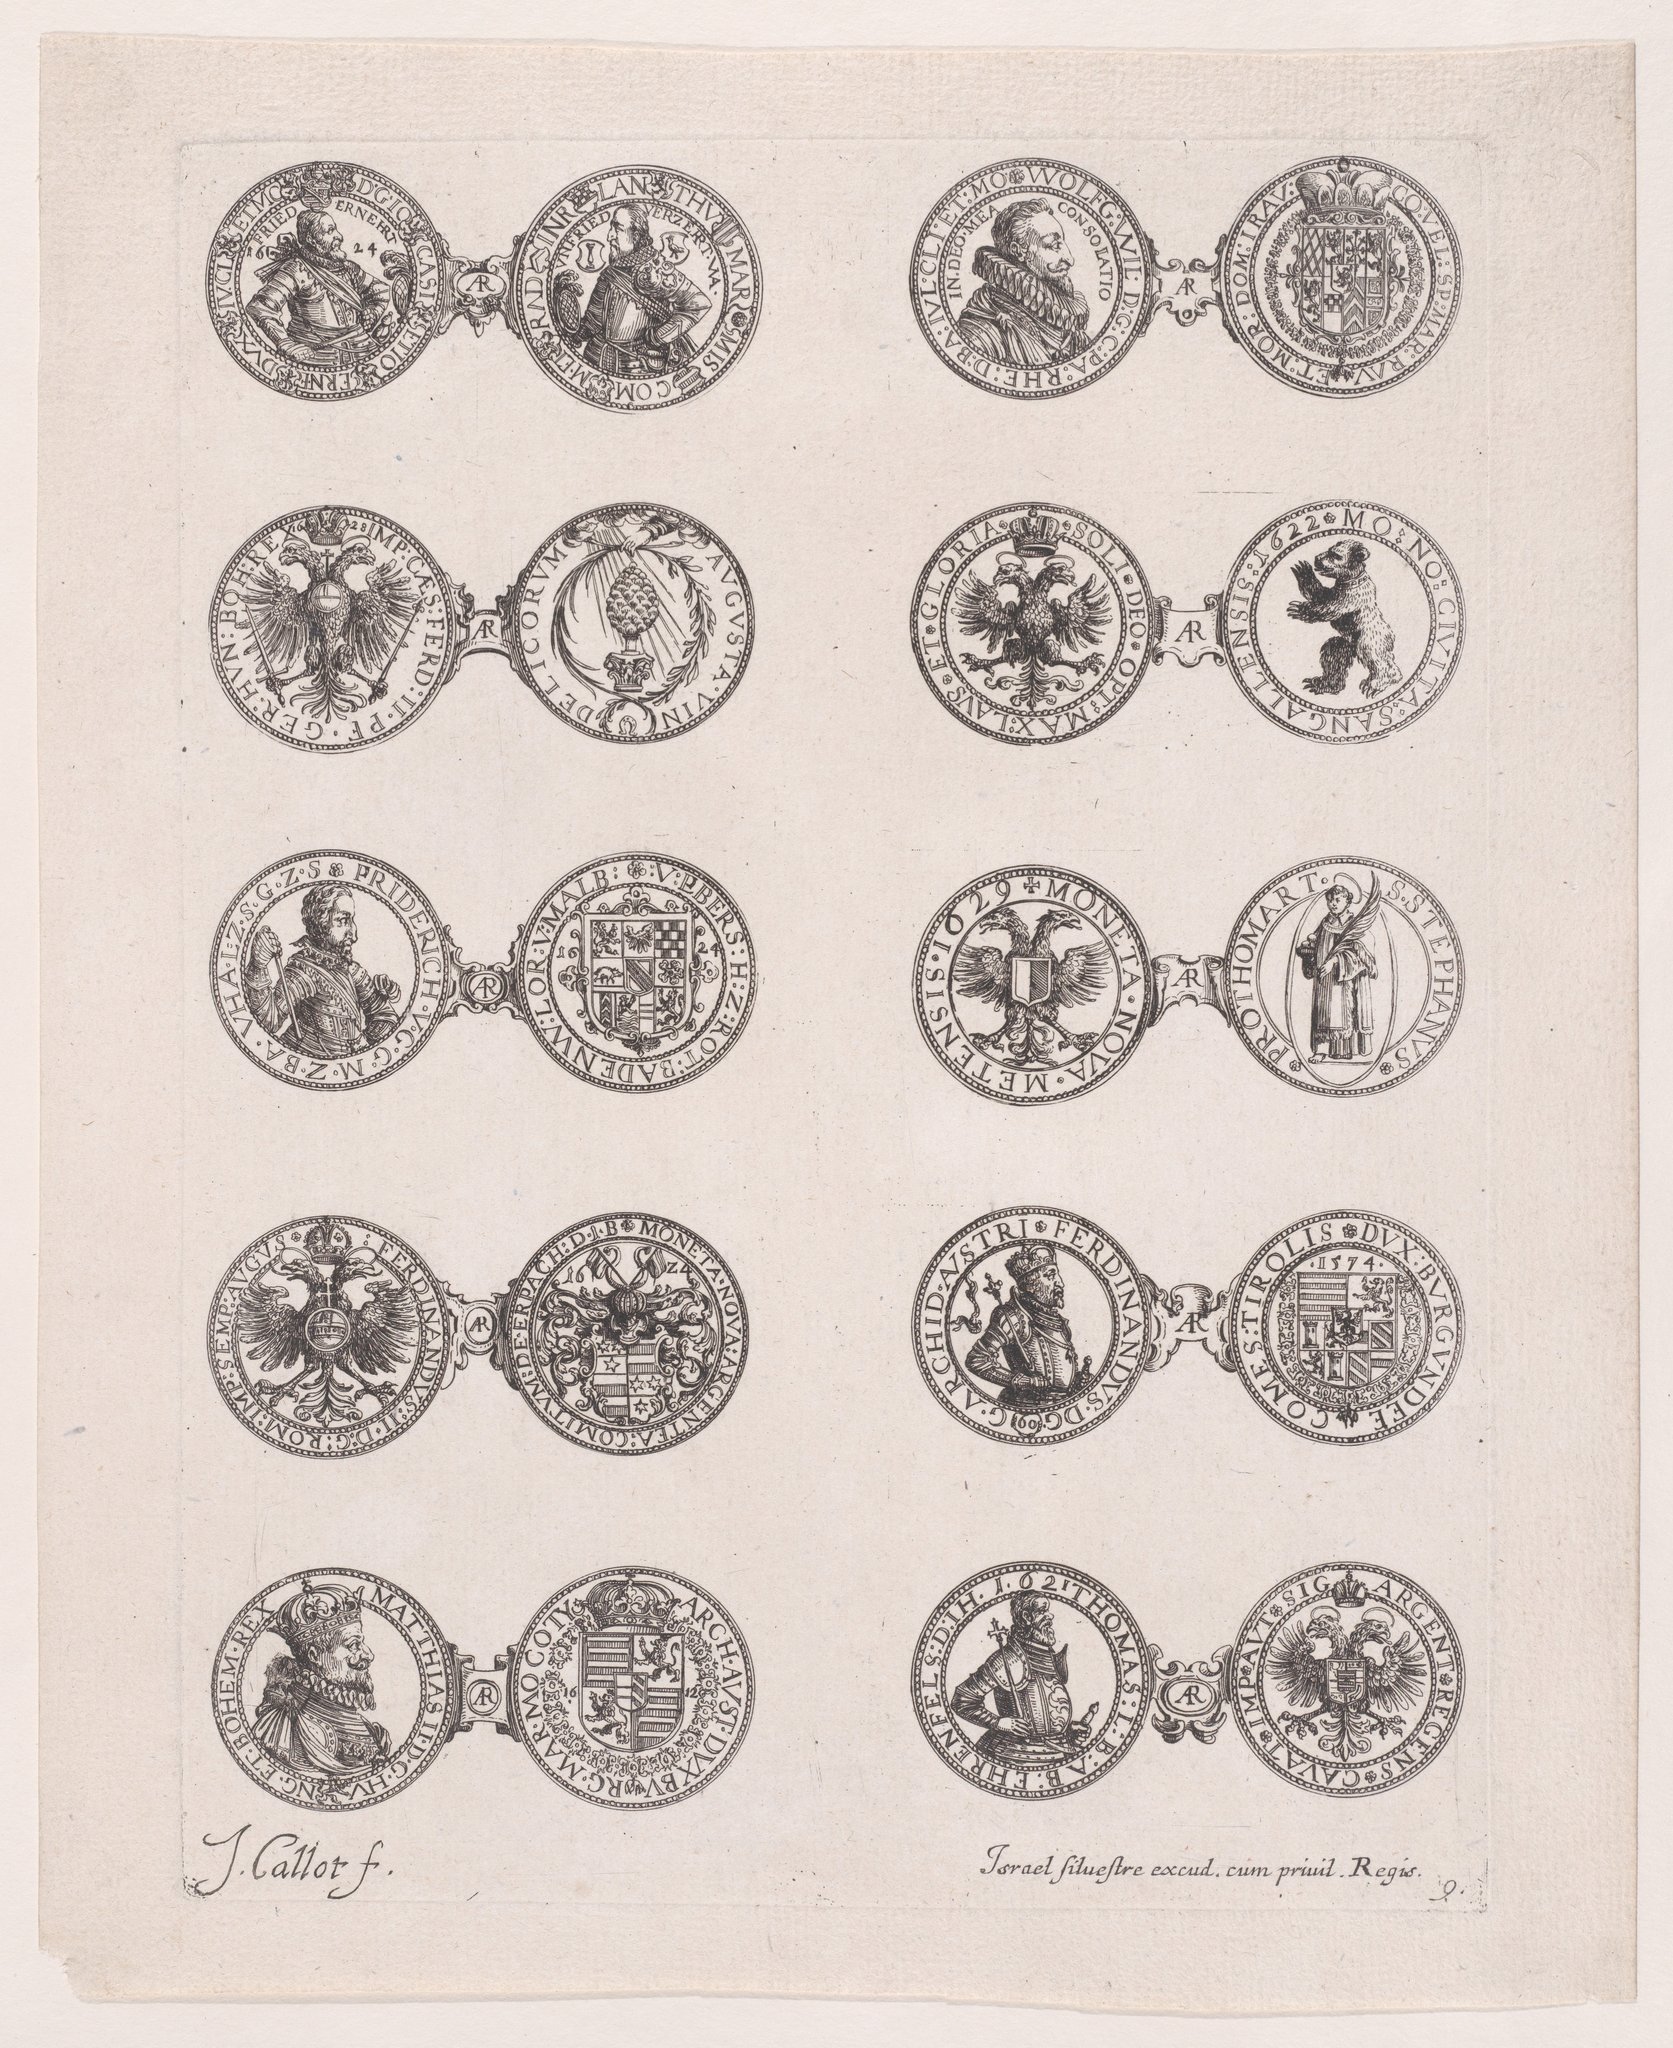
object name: print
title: Plate 9, Featuring 10 Coins Issued by European Princes in the 16th and 17th centuries, from "Les Monnaies" (The Currencies)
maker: jacques callot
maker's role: artist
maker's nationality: french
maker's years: 1592-1635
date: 1630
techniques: etching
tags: coins